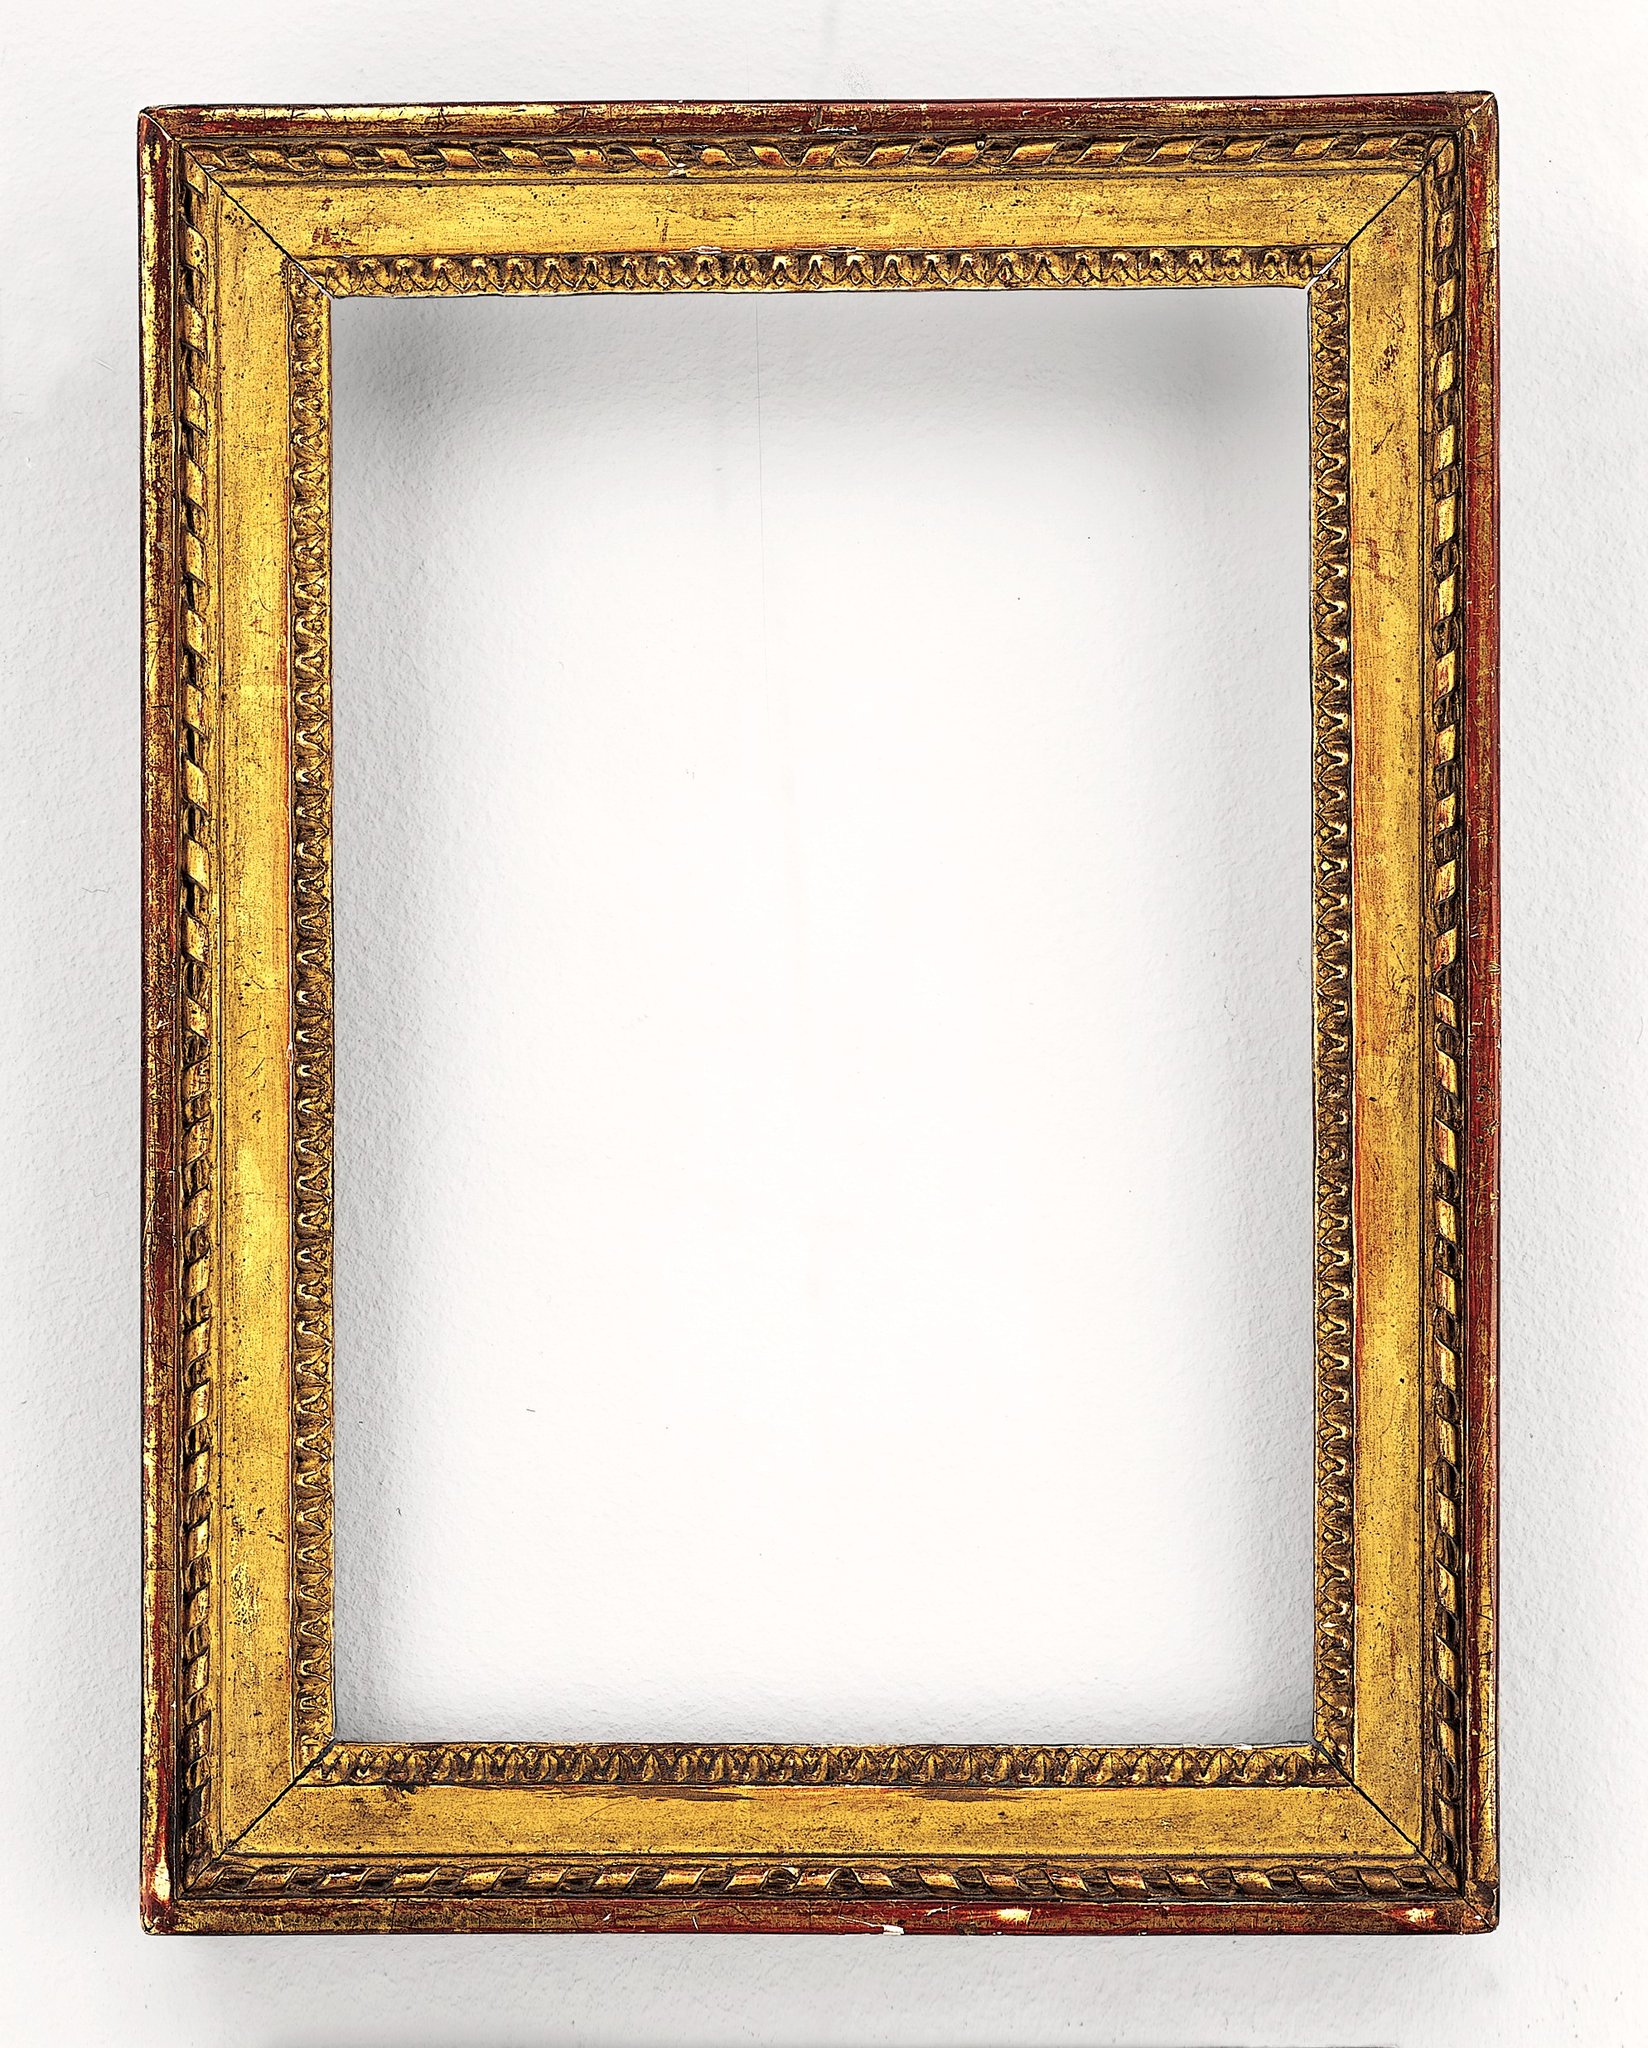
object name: frame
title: Cassetta frame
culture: french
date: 1790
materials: wood